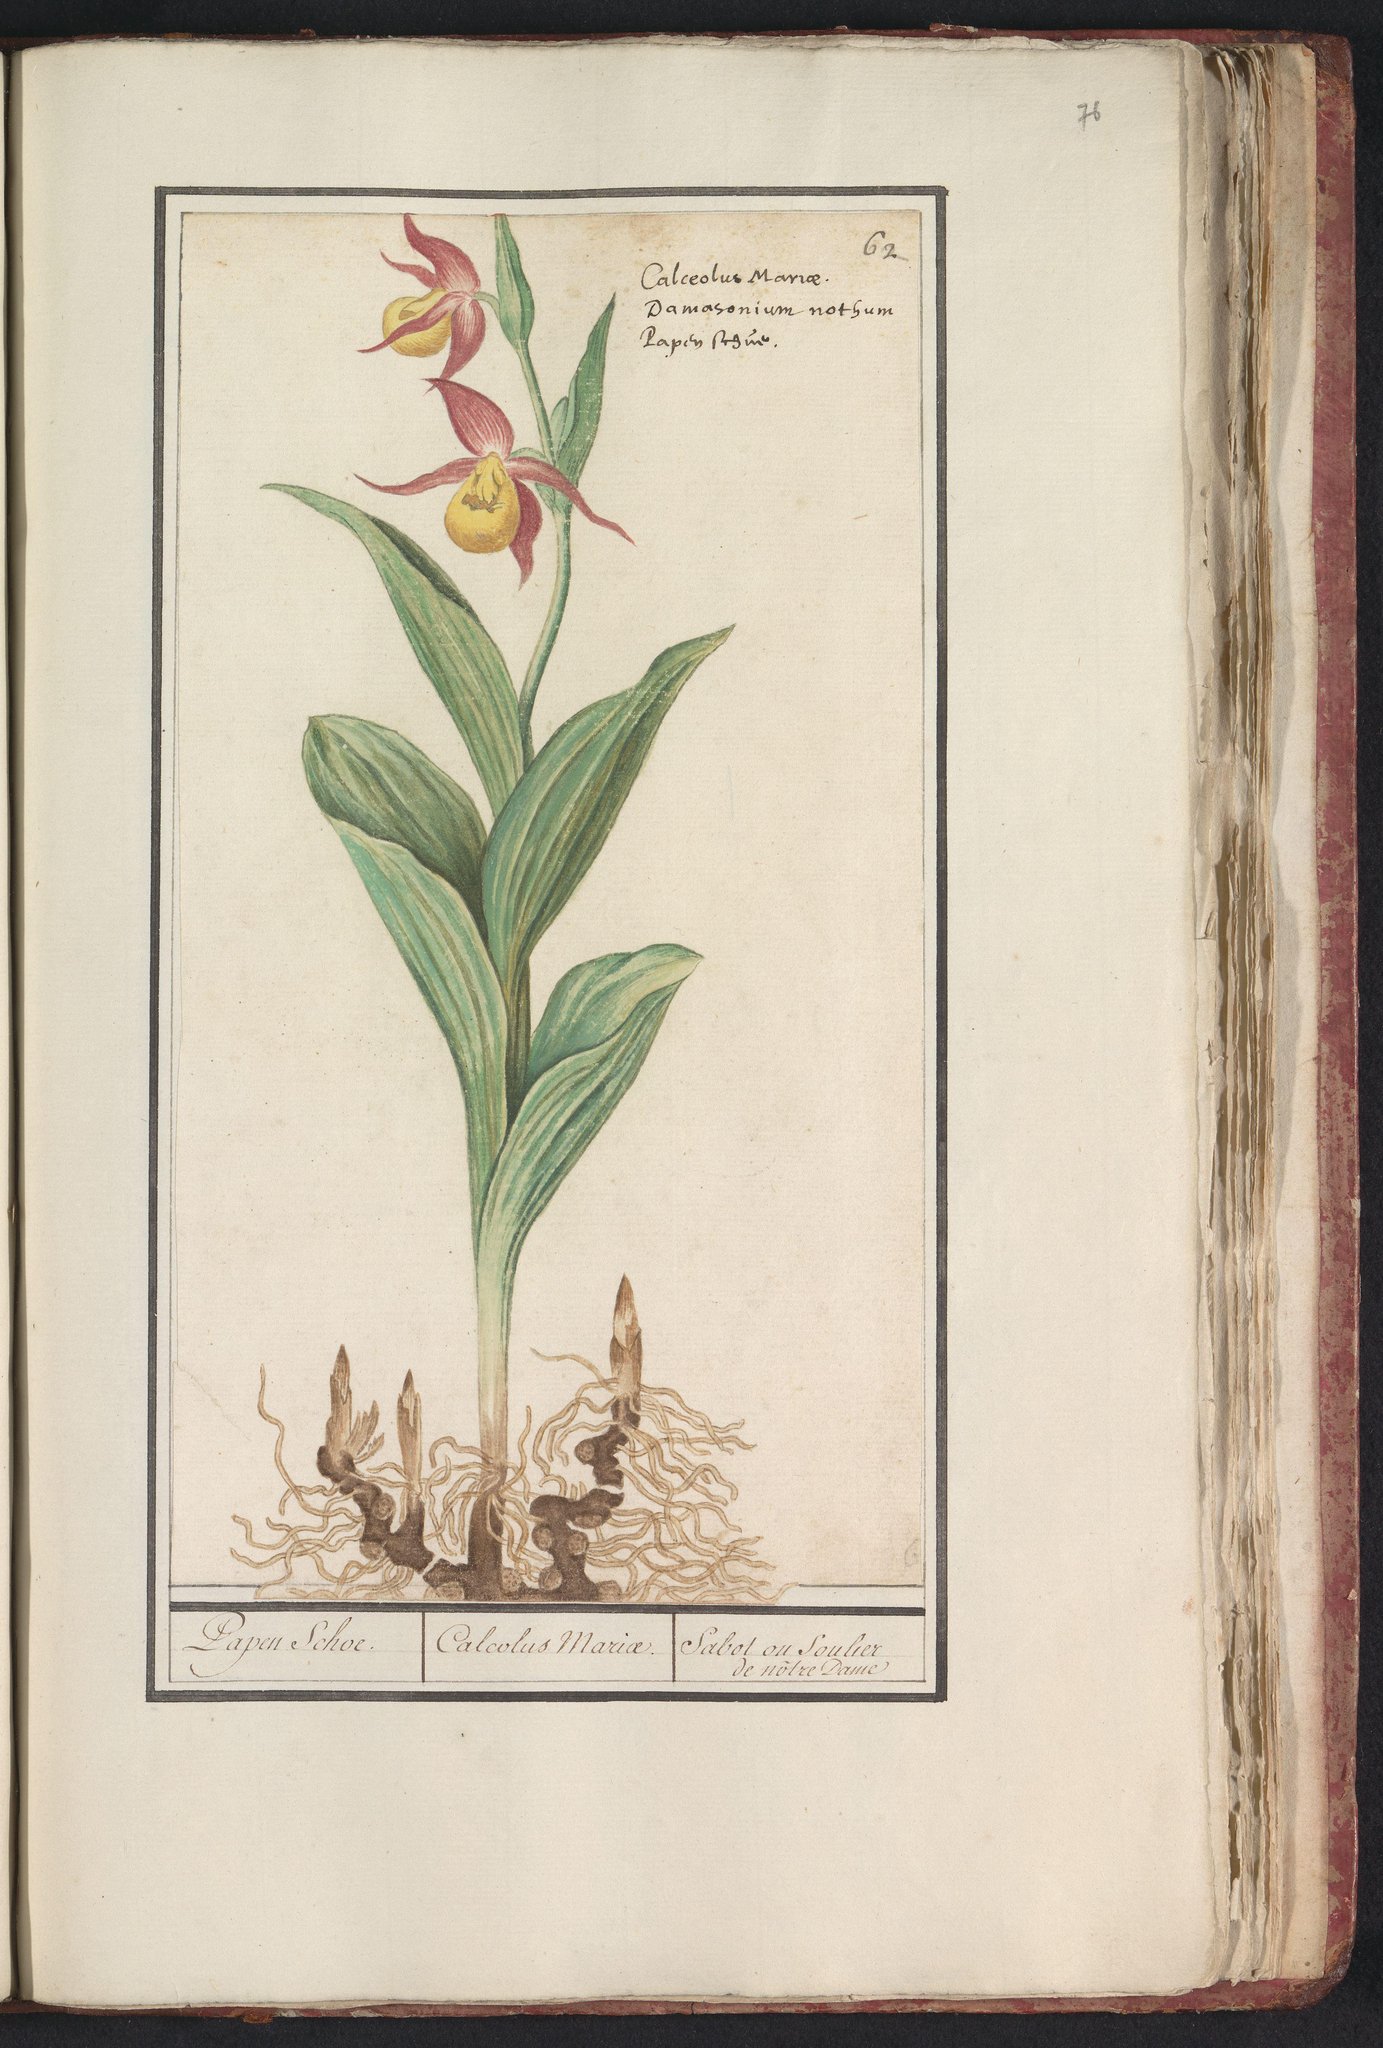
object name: drawing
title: Vrouwenschoentje (Cypripedium calceolus)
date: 1596-1610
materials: chalk, paint, ink, paper, watercolor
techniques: brush, pen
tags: flowers: orchid, flowers: lady's-slipper orchid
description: Orchidee vrouwenschoentje of venusschoentje. Genummerd rechtsboven: 62. Hier ook de naam in drie talen. Onderdeel van het eerste album met tekeningen van bloemen en planten. Achtste van twaalf albums met tekeningen van dieren, vogels en planten bekend rond 1600, gemaakt in opdracht van keizer Rudolf II. Met toelichting in Nederlands, Latijn en Frans.